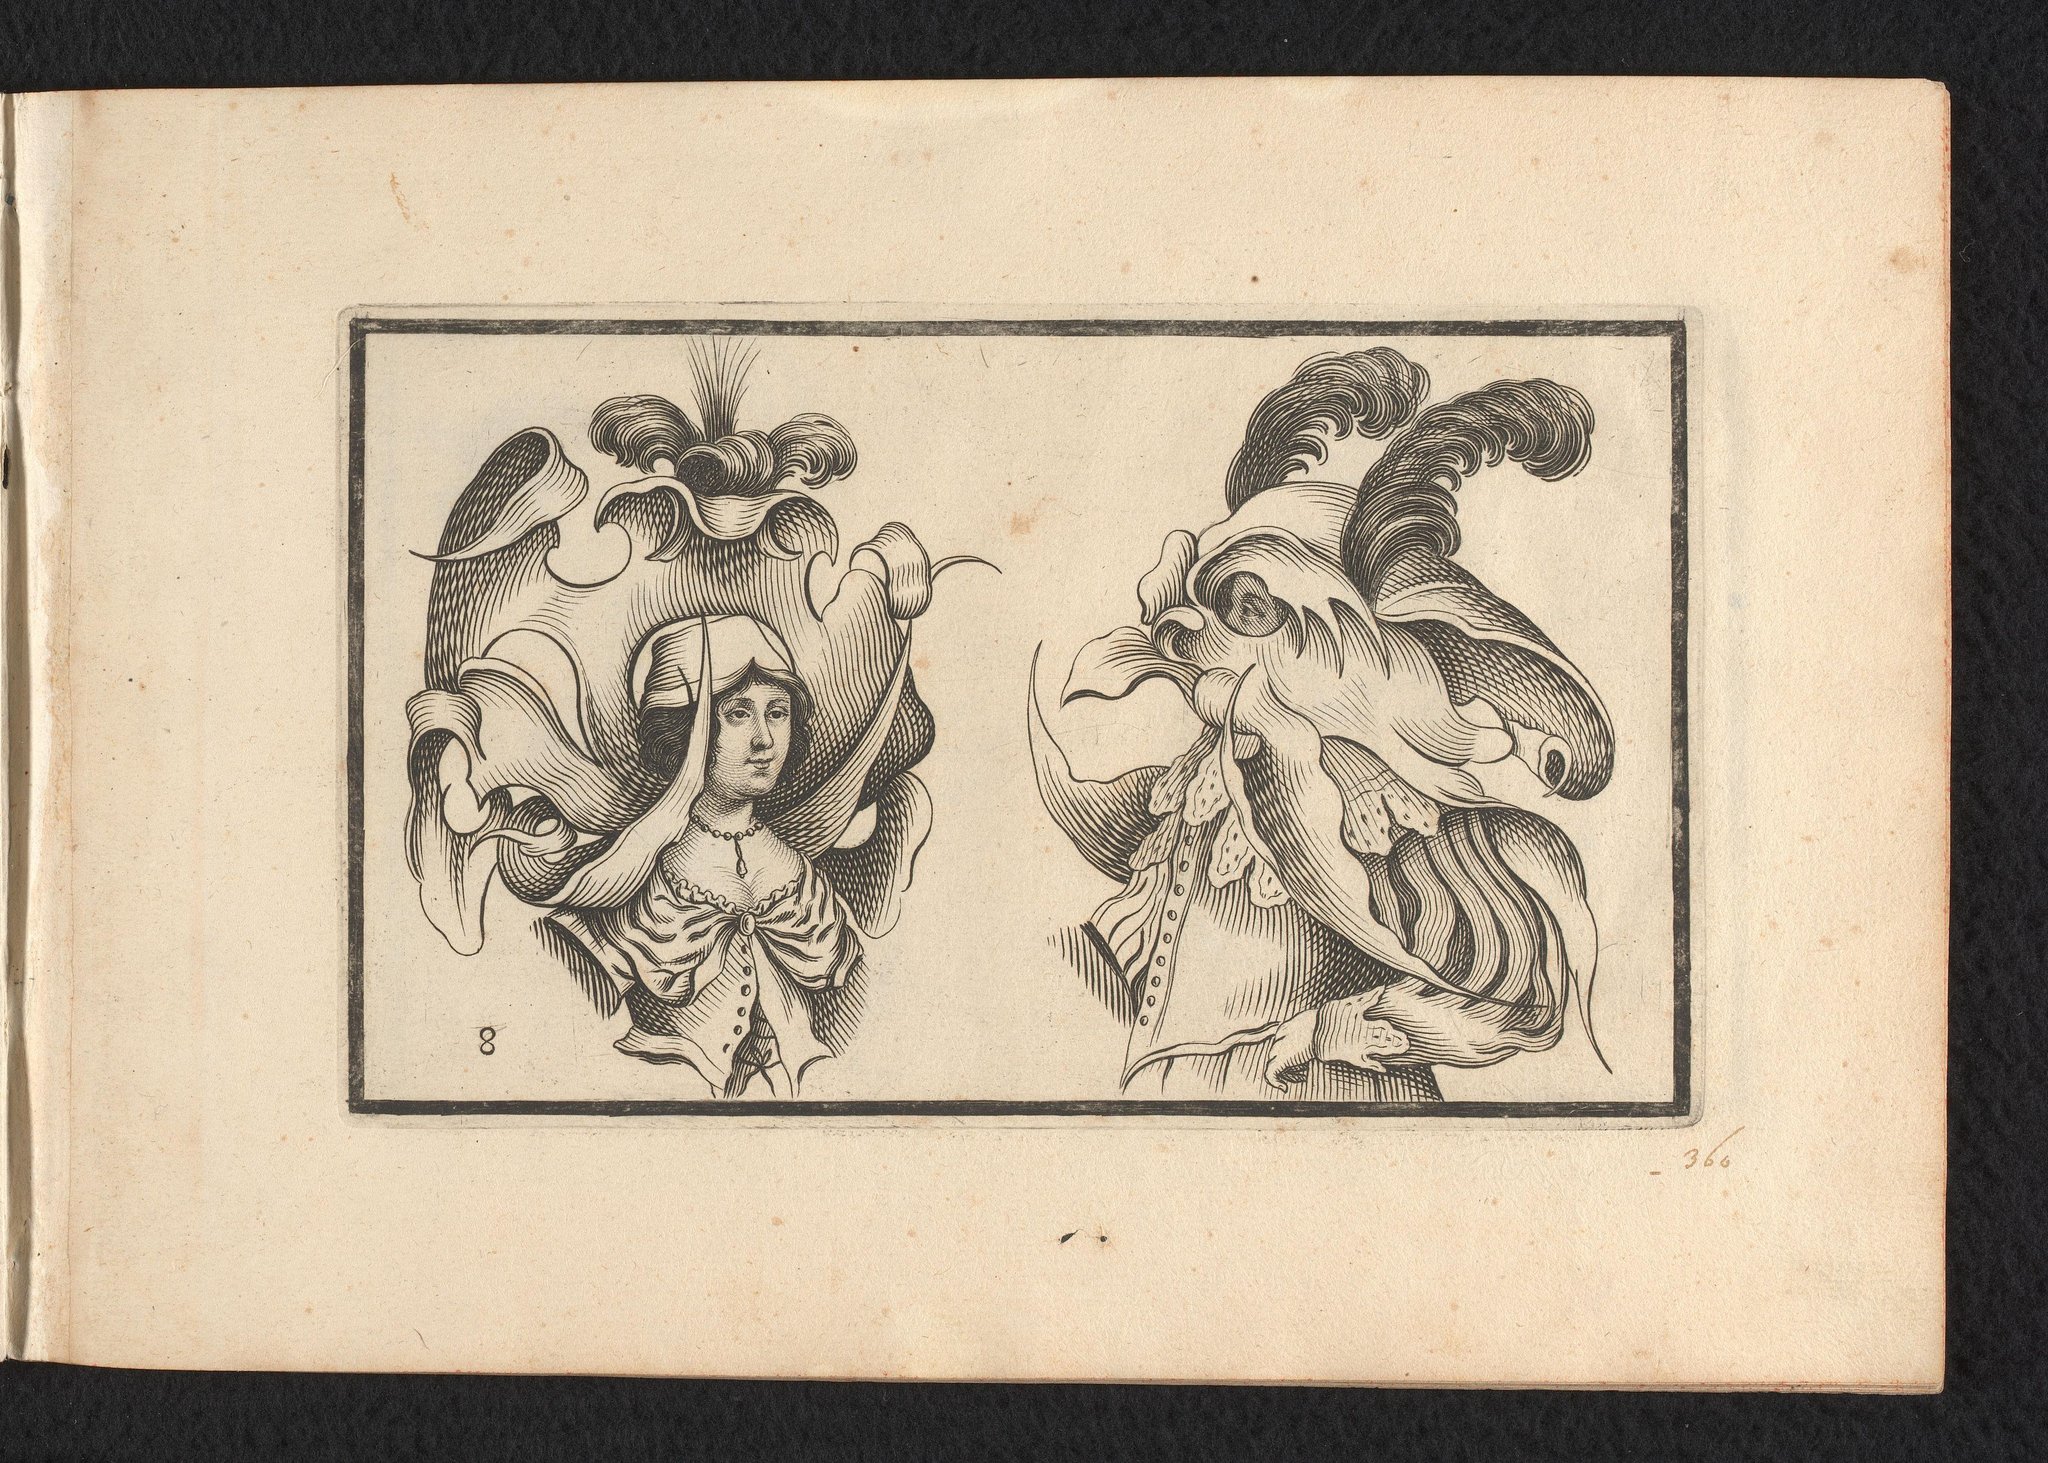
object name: print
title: Twee vrouwenkoppen met groteske hoeden en kragen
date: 1636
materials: paper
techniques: engraving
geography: paris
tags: ornaments ~ art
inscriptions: collector's mark: Lugt 2228, number: ‘360’, collector's mark: Lugt 2760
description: Deze prent maakt deel uit van een album.